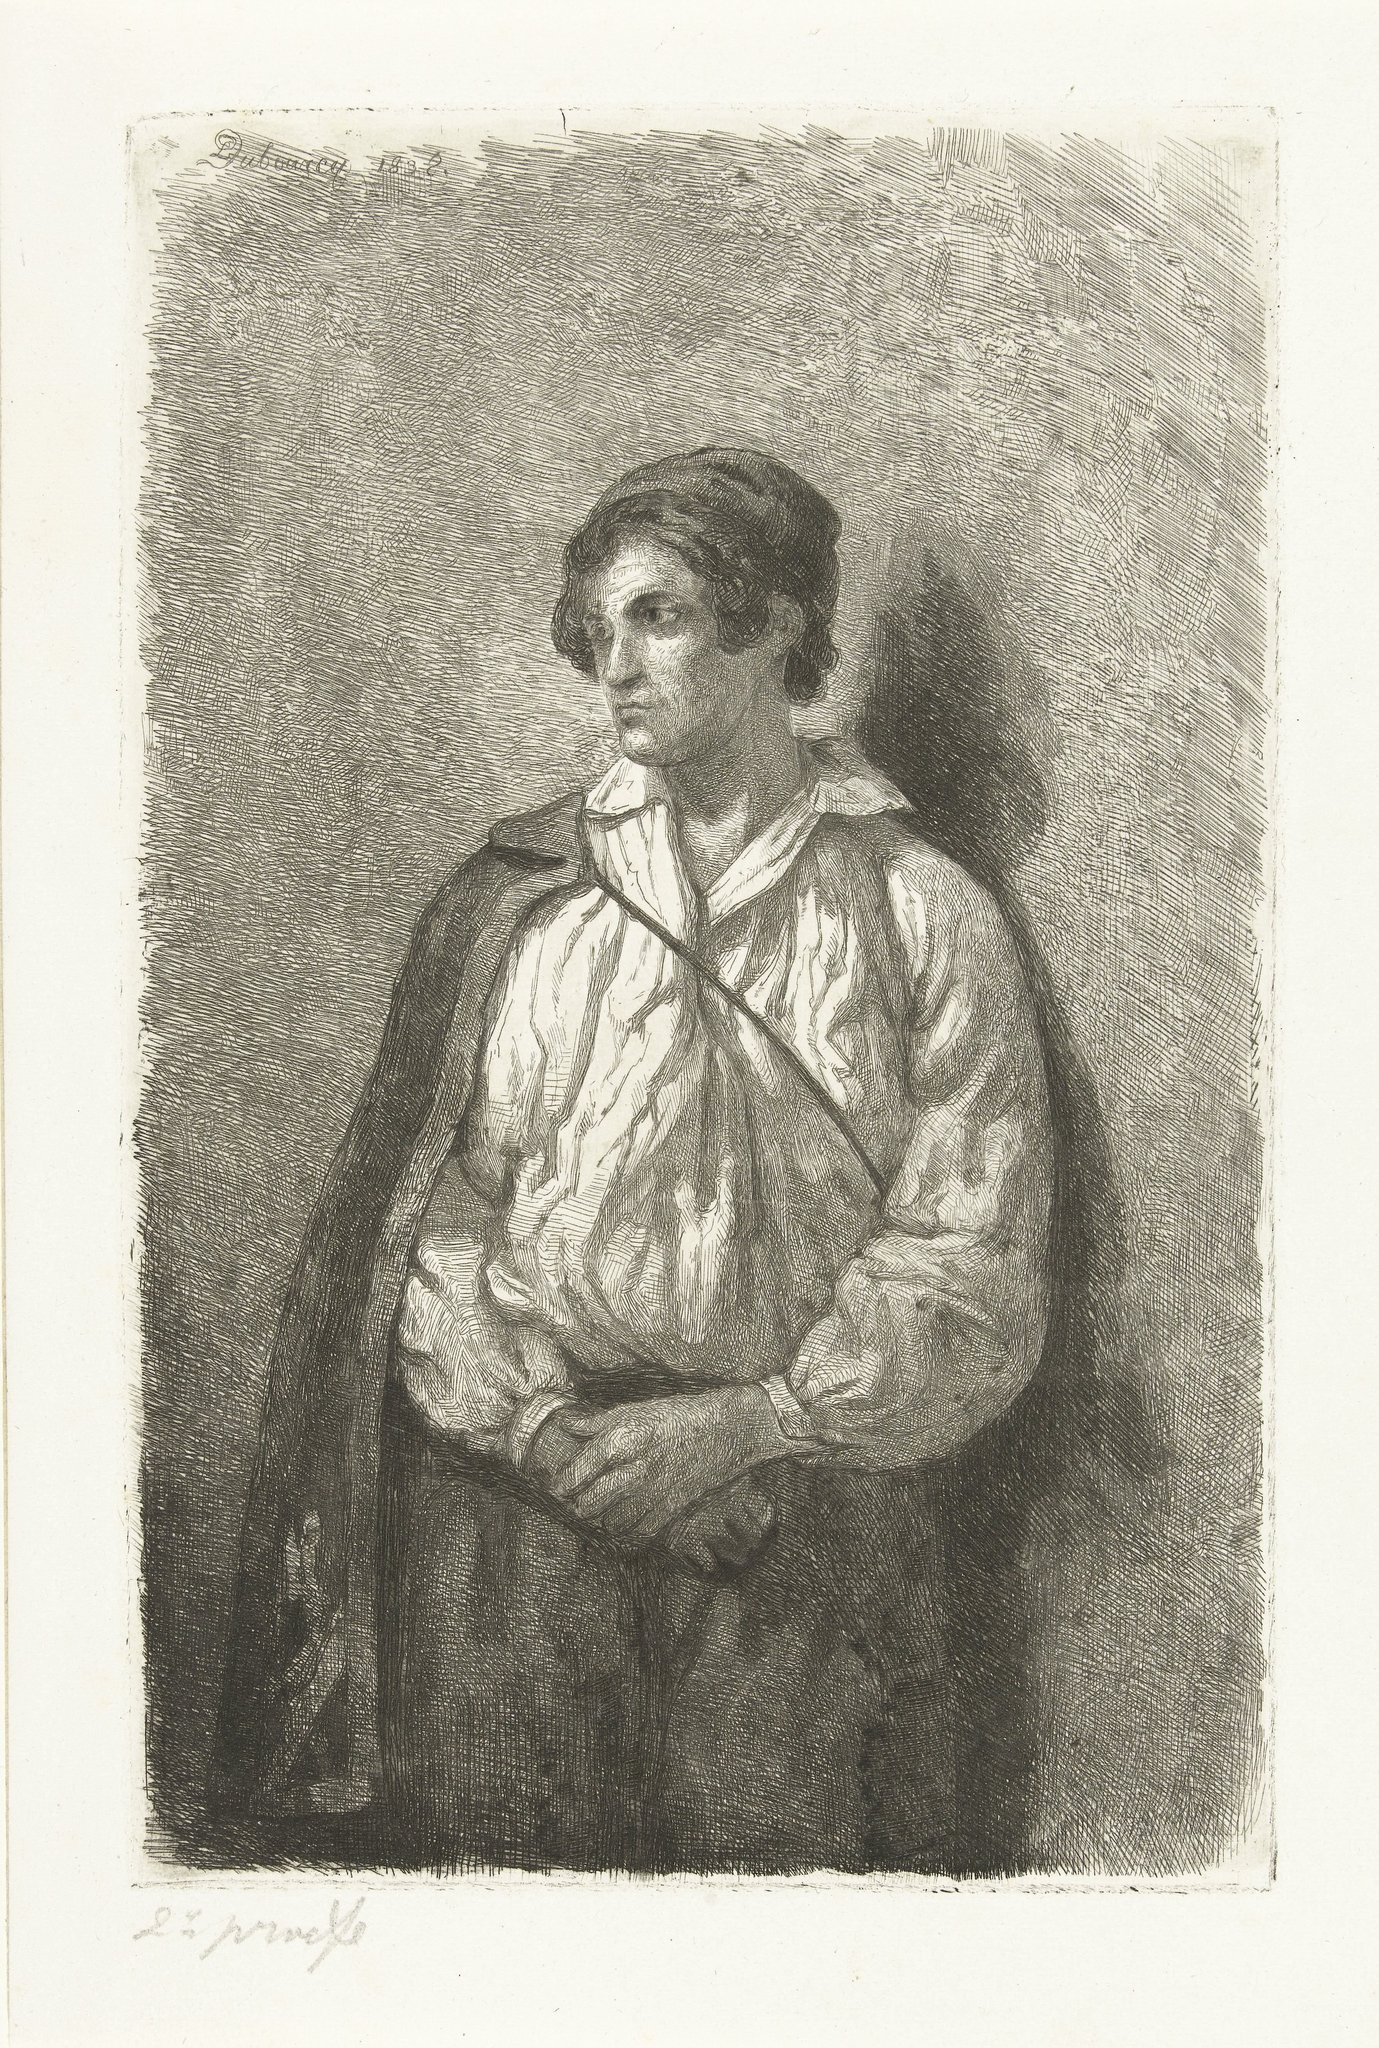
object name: print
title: Portret van een onbekende jonge man met muts en cape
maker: pierre louis dubourcq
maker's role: draughtsman, painter, print maker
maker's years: 1815-1873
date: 1832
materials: paper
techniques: etching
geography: netherlands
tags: anonymous historical person portrayed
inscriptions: collector's mark: Lugt 2228